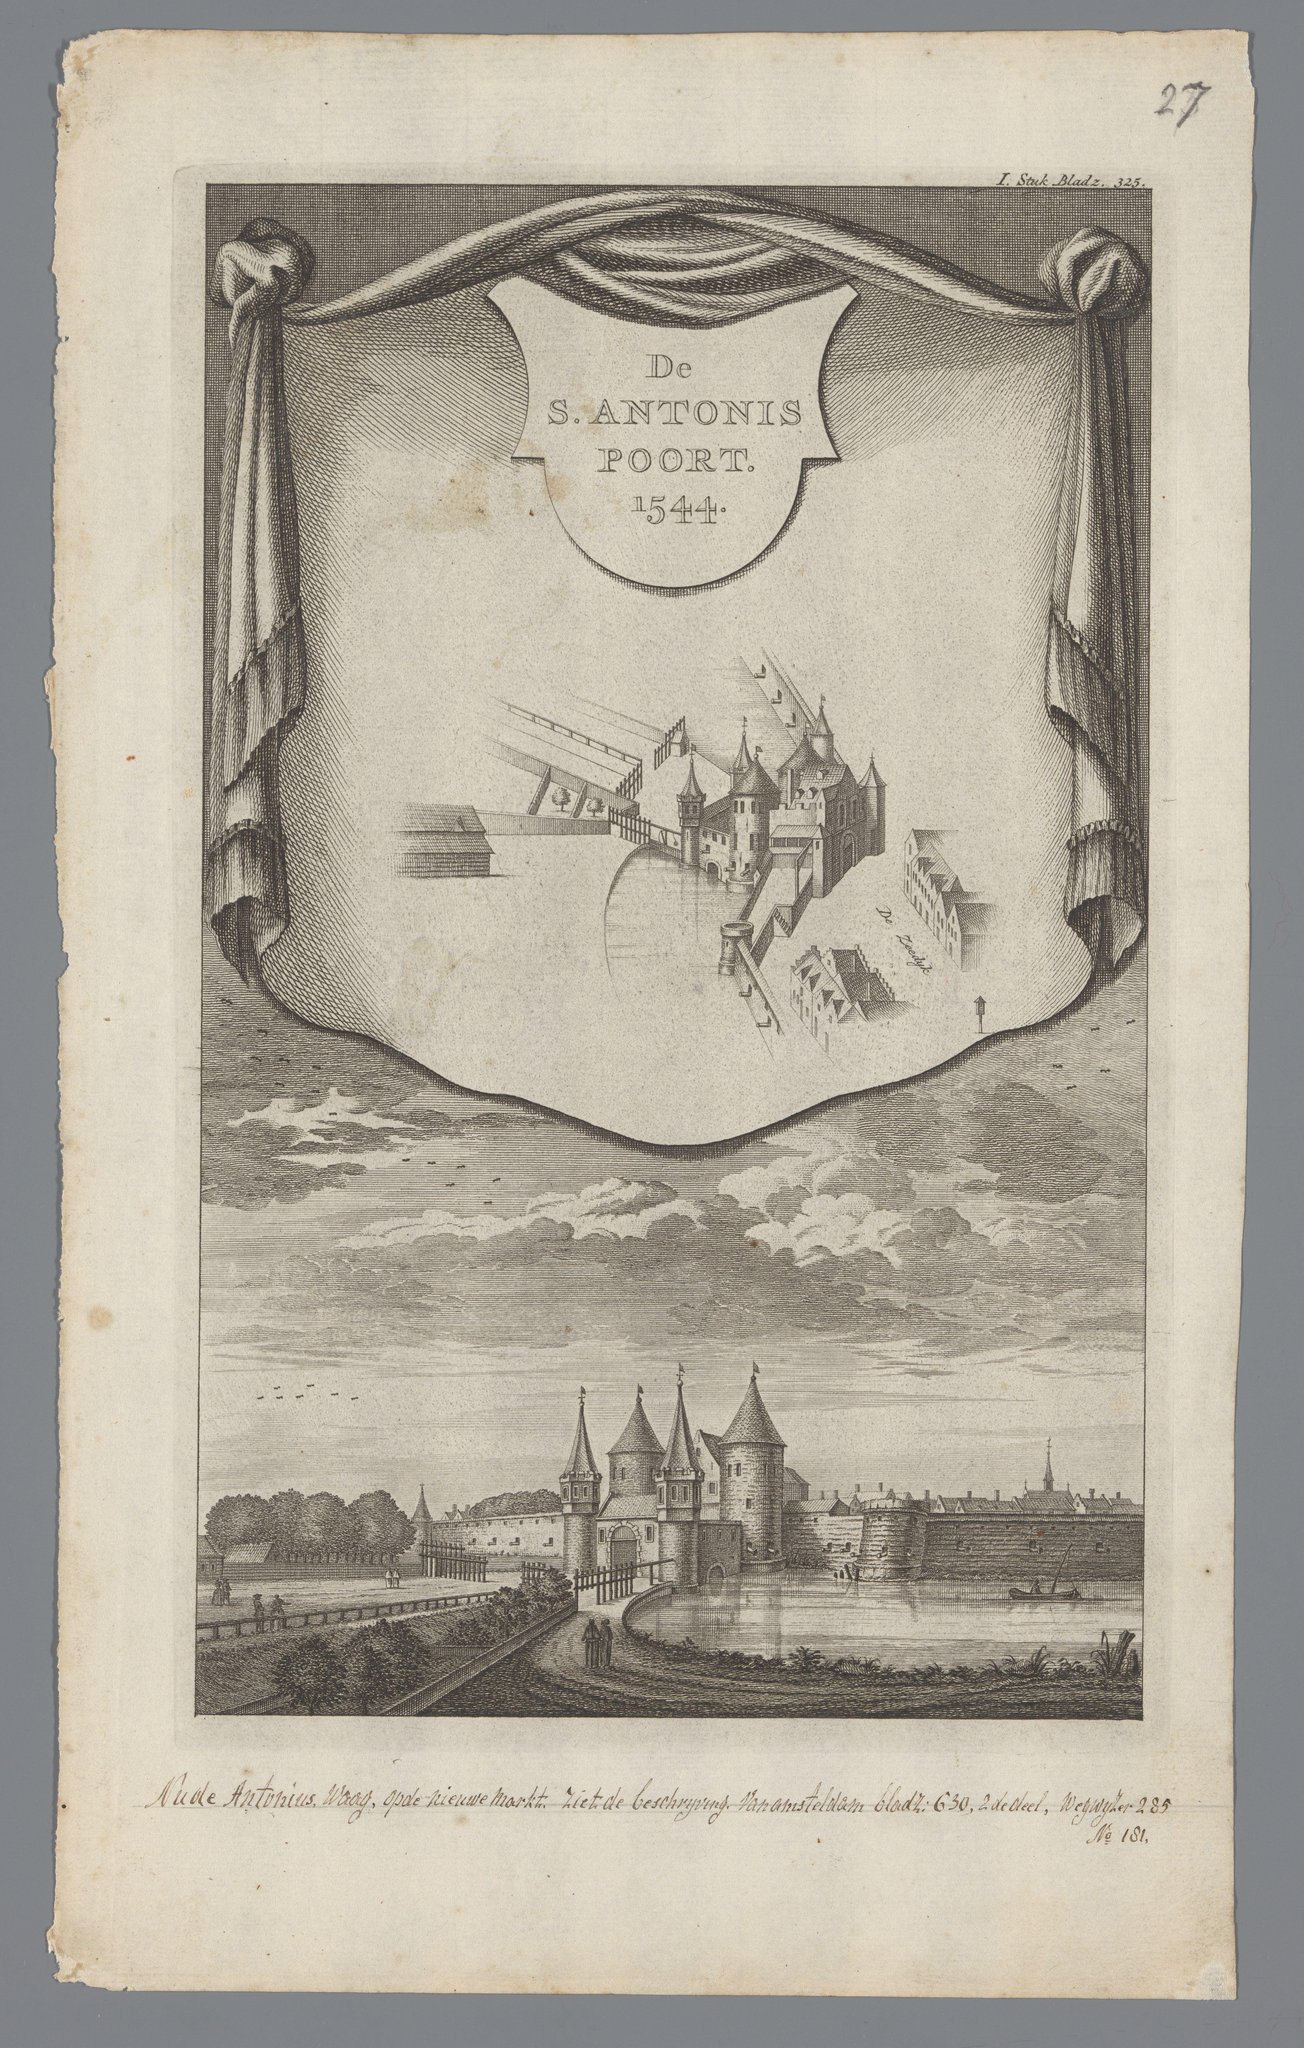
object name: print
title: Gezichten op de Eerste Sint-Antoniespoort in Amsterdam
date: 1760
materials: paper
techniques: engraving, etching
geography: amsterdam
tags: bridge in city across river, canal, etc., city-gate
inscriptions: annotation: ‘Beschrijving van de prent’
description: Prent uit: Wagenaar, Jan. Amsterdam, in zyne opkomst, aanwas, geschiedenissen (...). 2 dln. Amsterdam: Isaak Tirion, 1760, dl. 1, p. 325.